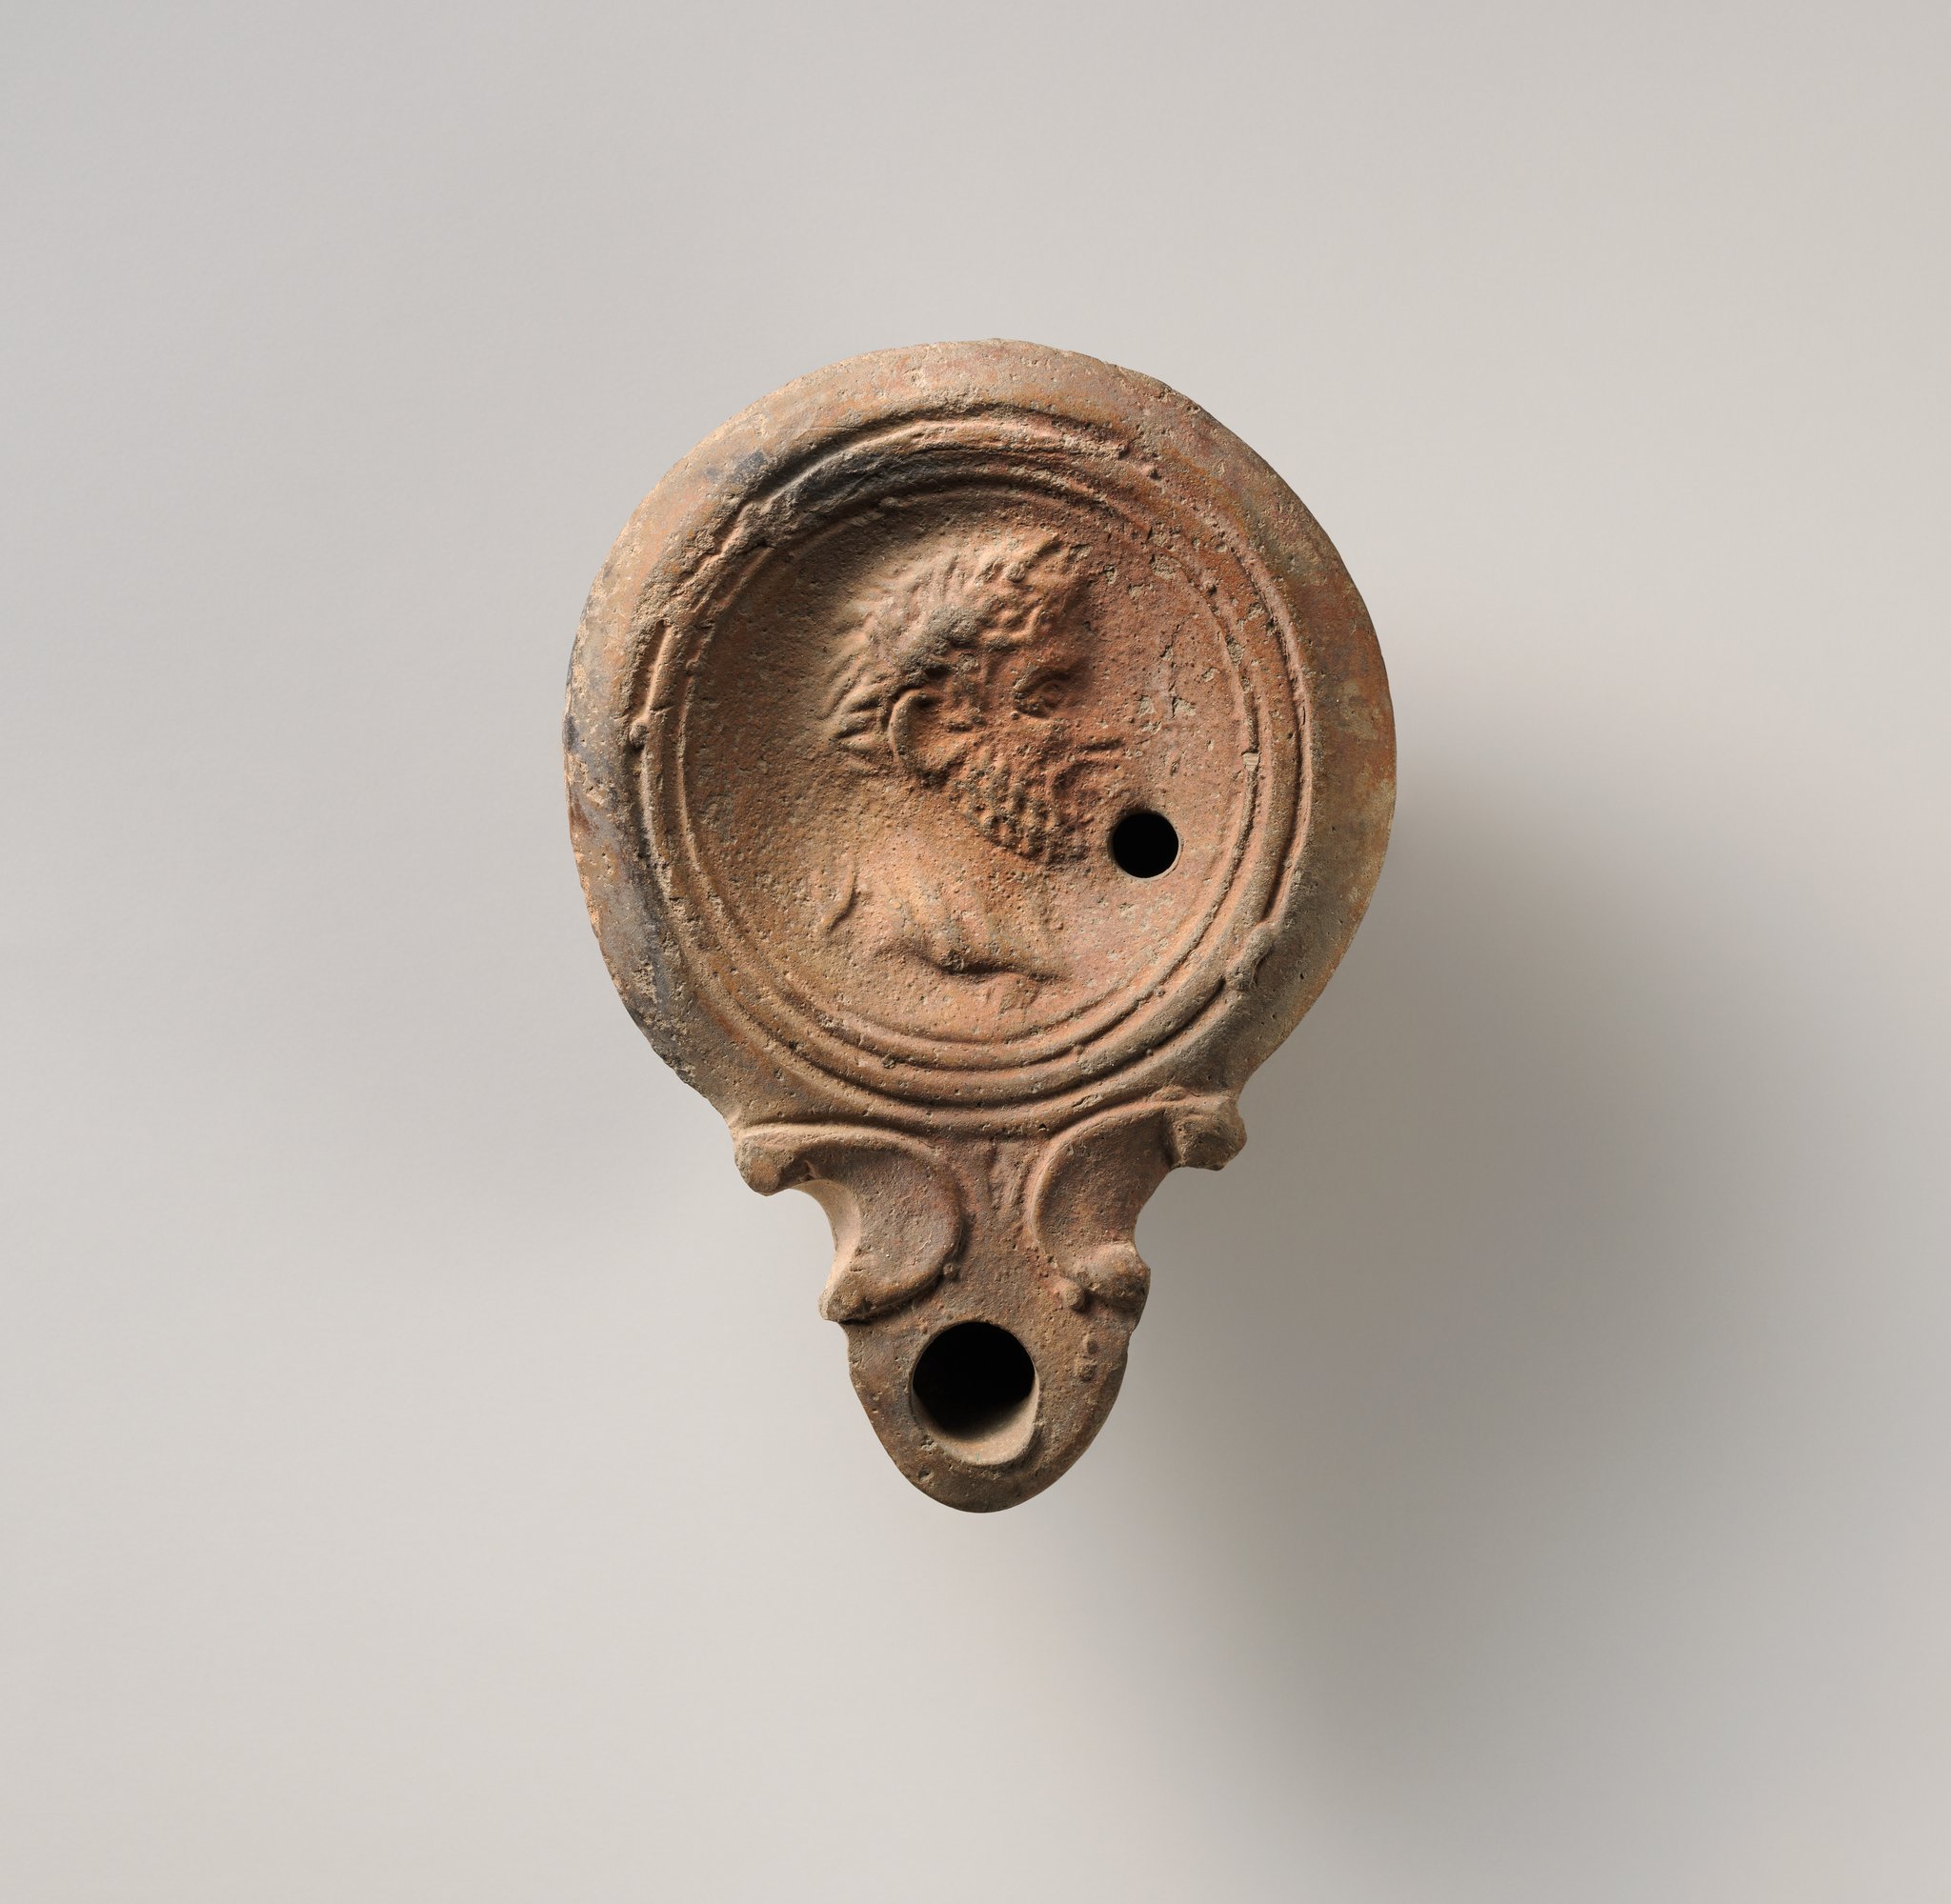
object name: lamp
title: Terracotta oil lamp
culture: roman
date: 101-200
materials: terracotta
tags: men